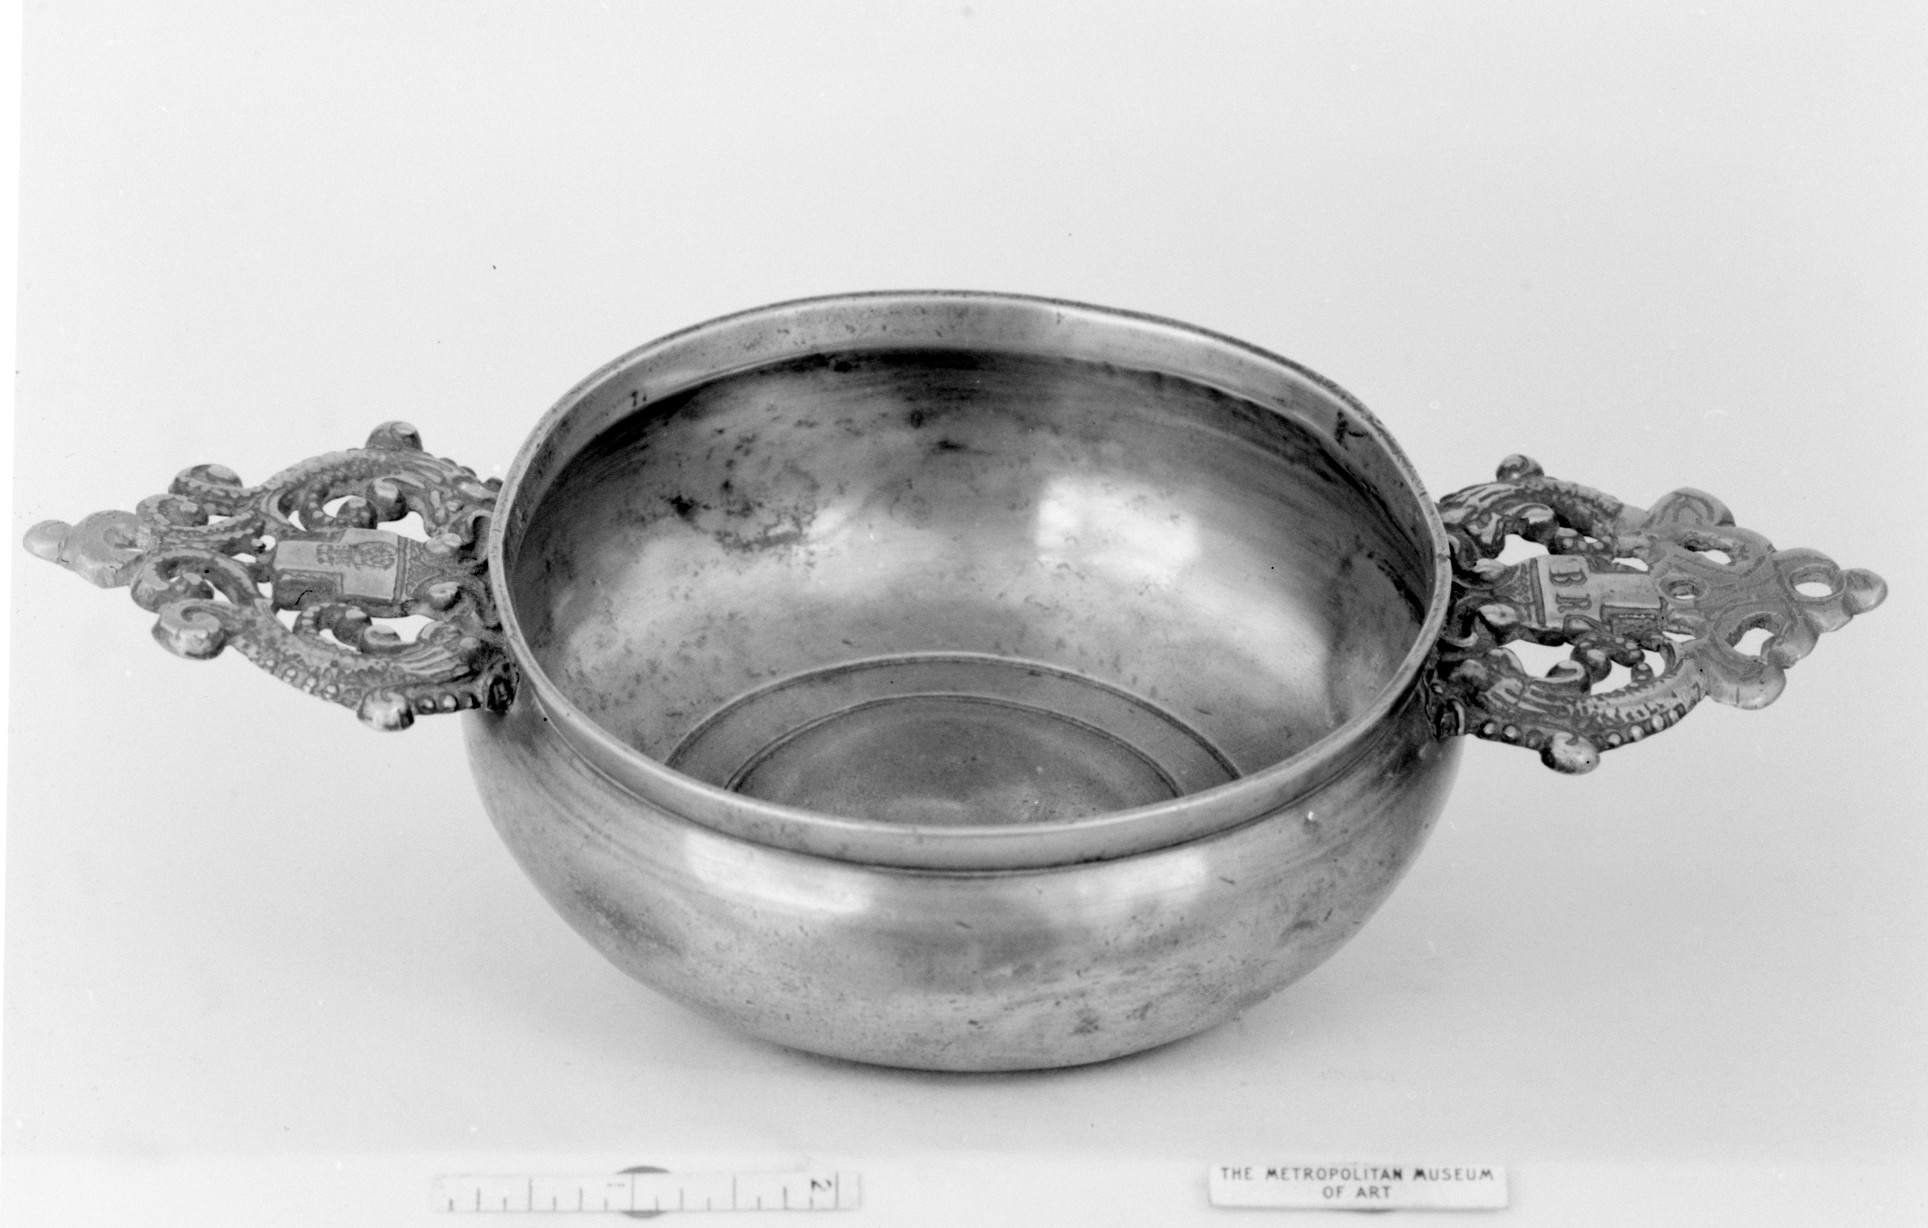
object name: porringer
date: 1601-1700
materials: pewter